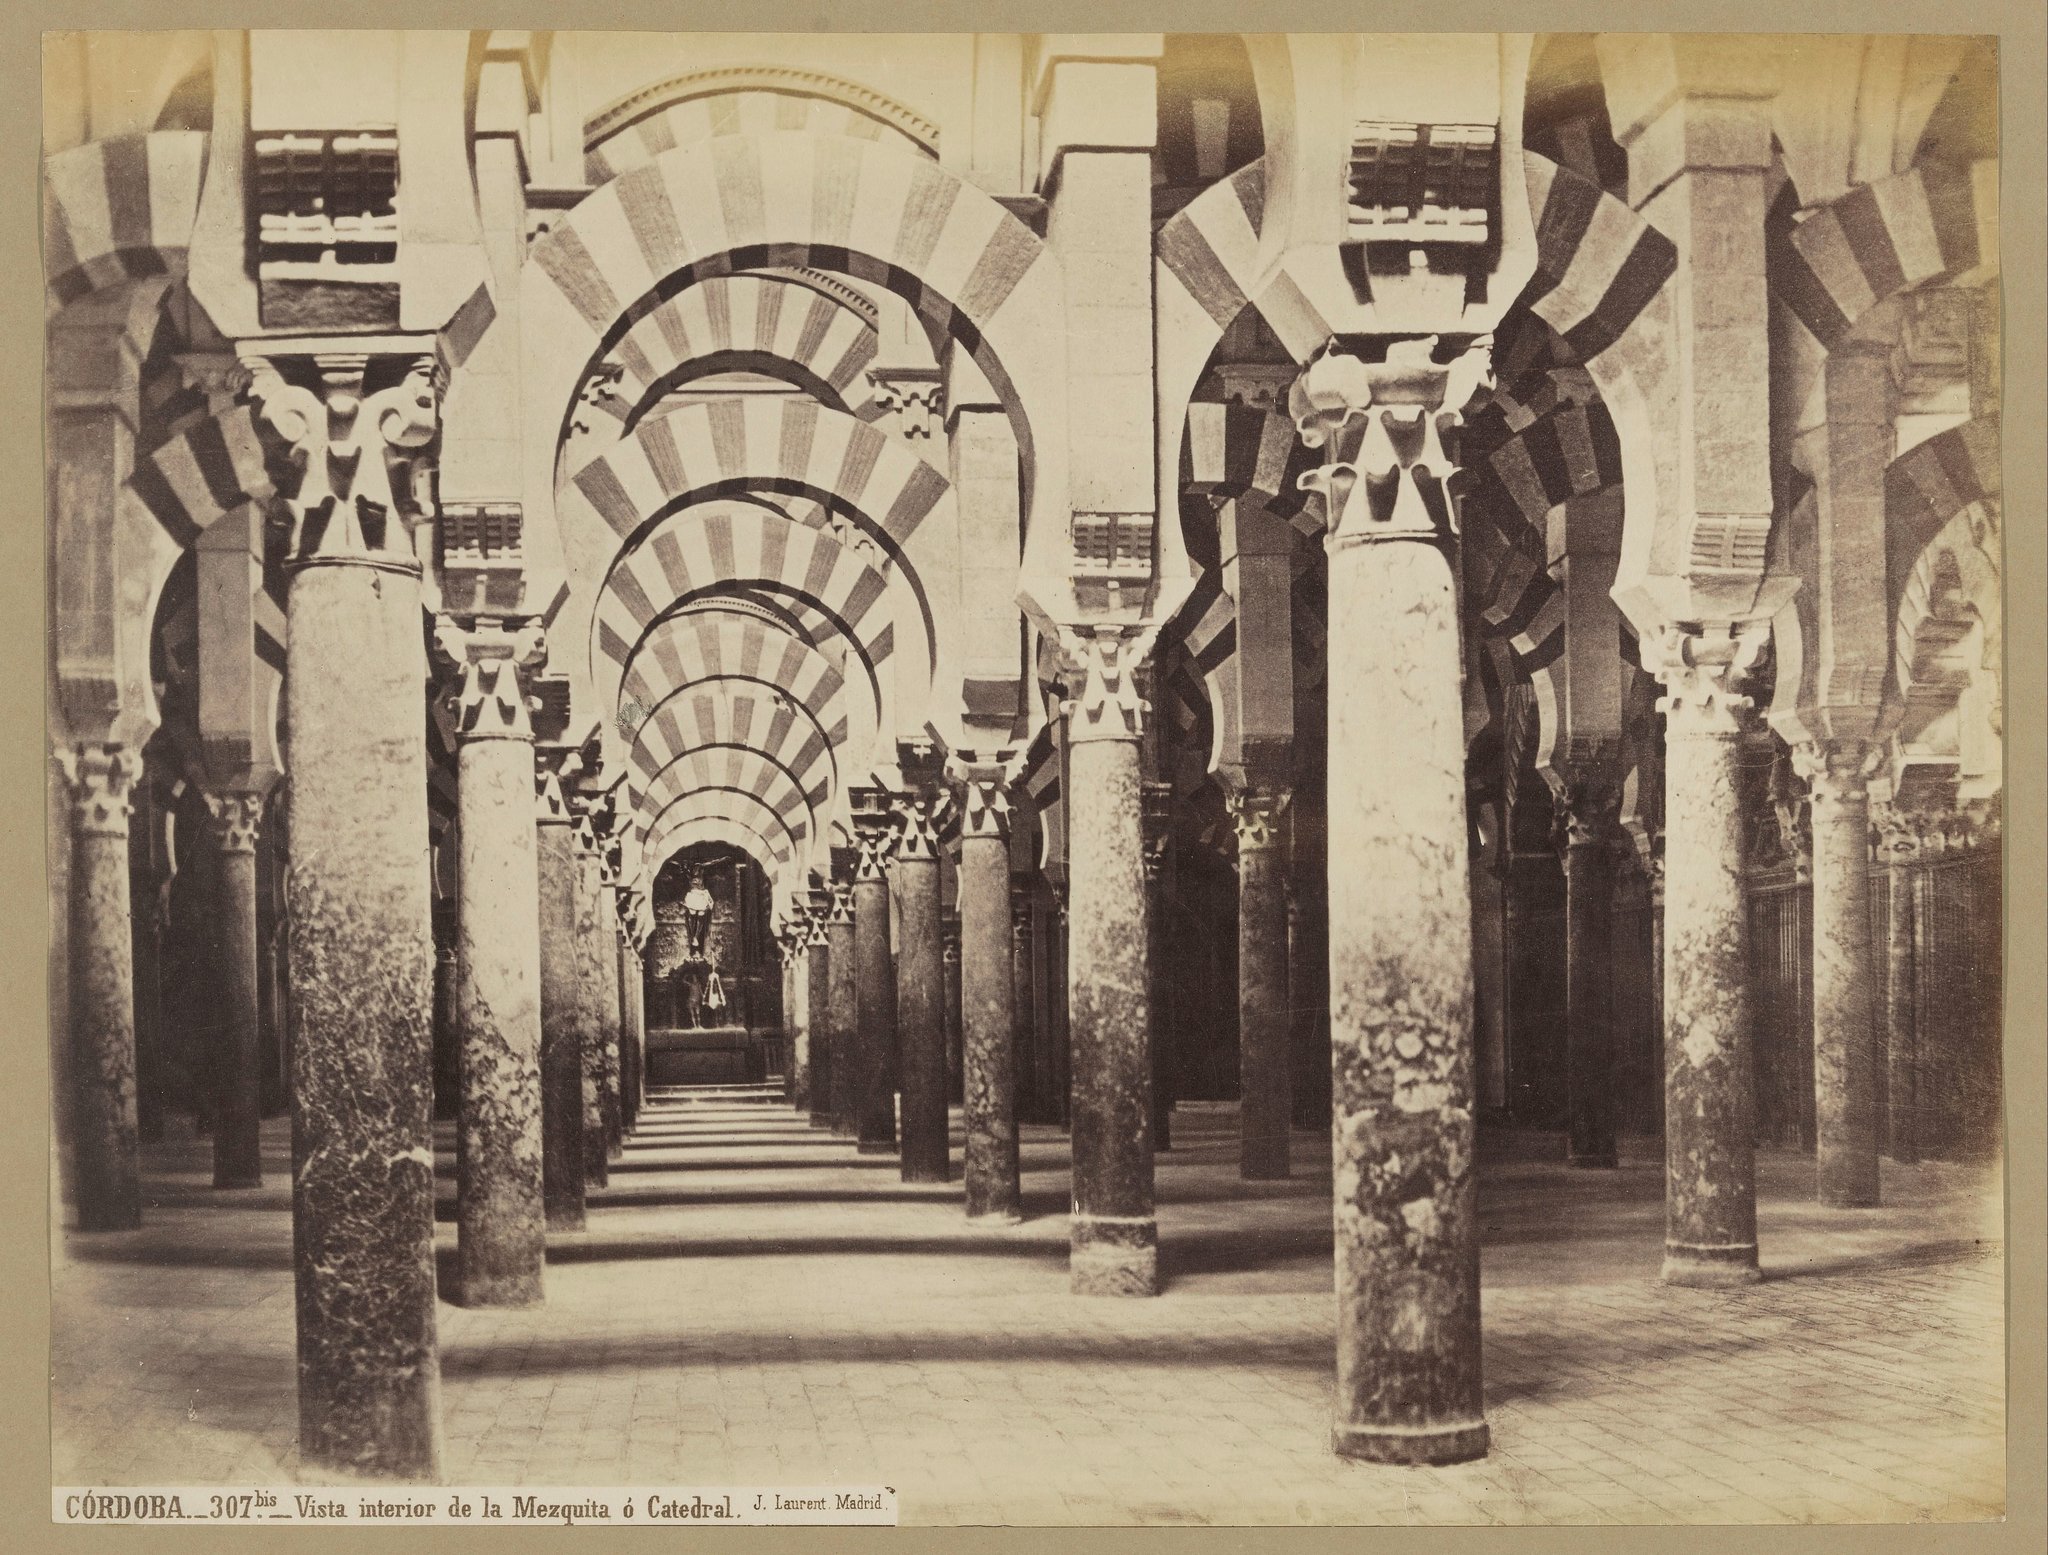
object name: album leaf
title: Córdoba, vista interior de la Mezquita ó Catedral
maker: juan laurent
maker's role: publisher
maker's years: 1816-1896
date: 1856-1863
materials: paper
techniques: albumen print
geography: córdoba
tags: interior of church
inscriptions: number: ‘307bis’